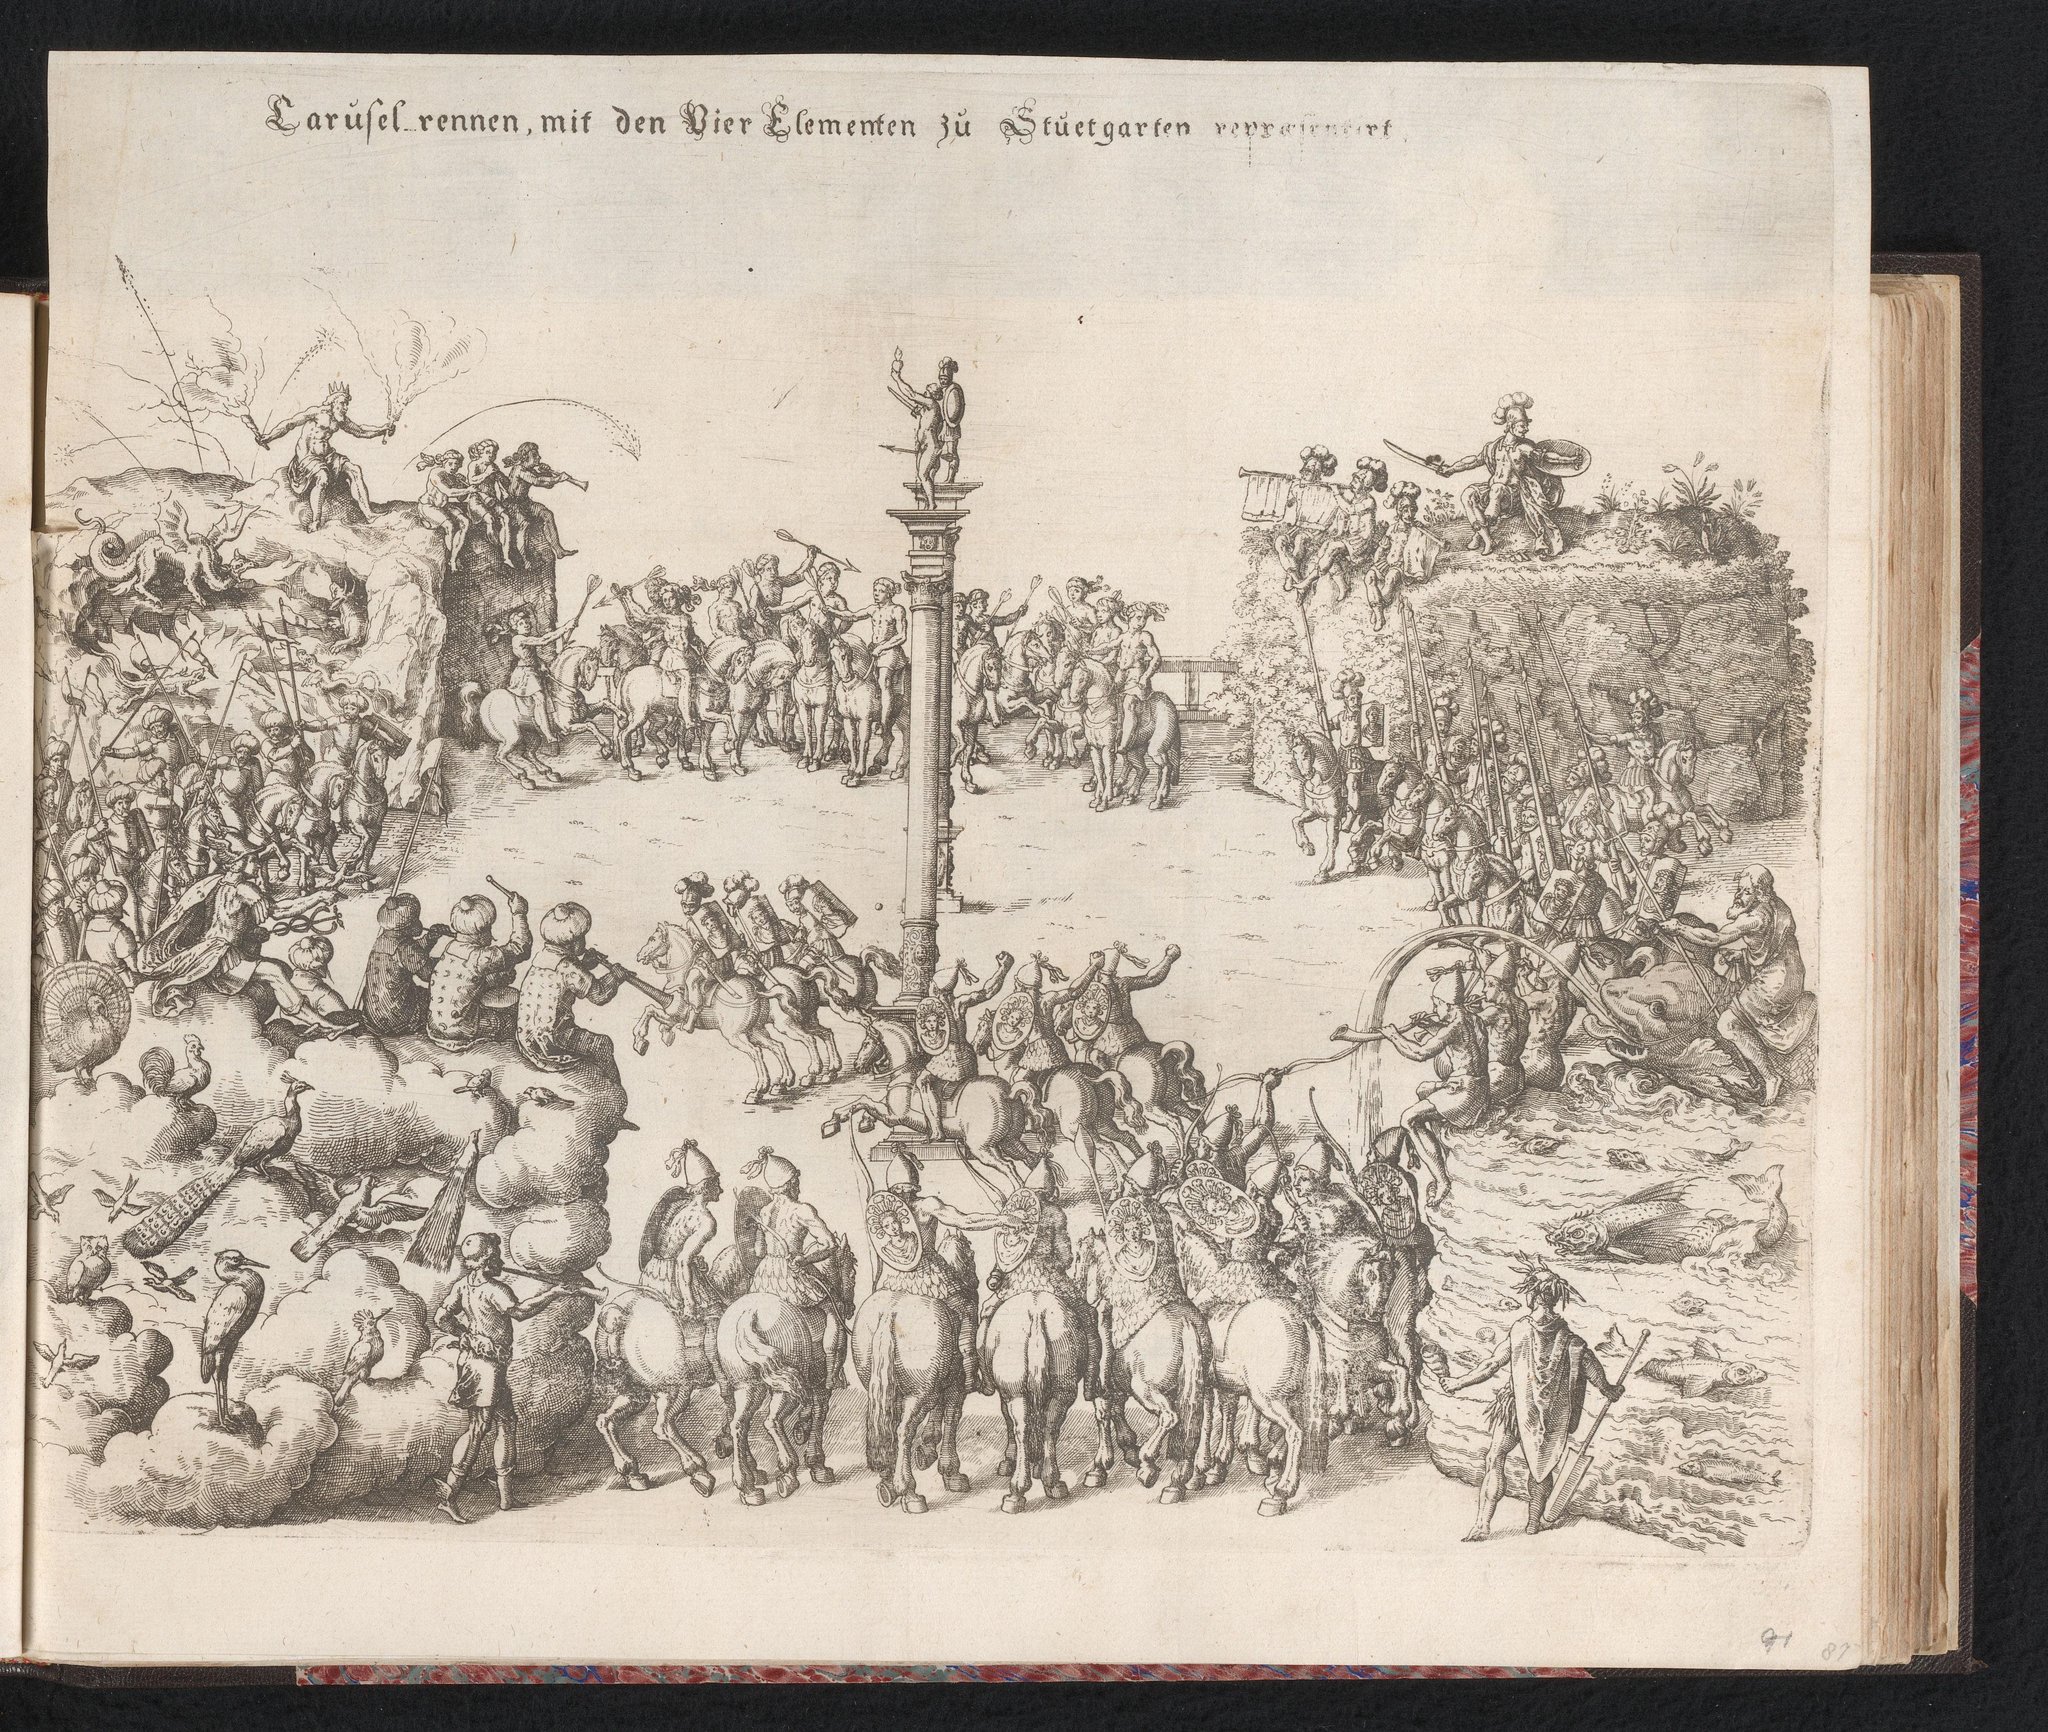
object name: album leaf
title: Aigentliche wahrhaffte Delineation unnd Abbildung aller fürstlichen Auffzüg und Rütterspilen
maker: friedrich brentel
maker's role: painter, print maker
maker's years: 1580-1651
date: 1618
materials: paper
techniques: etching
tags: the four elements, and ether, the fifth element, performance in the open air (pleasure fair), monument, statue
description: Tekst in het Duits bovenaan. Deze prent maakt deel uit van een album.